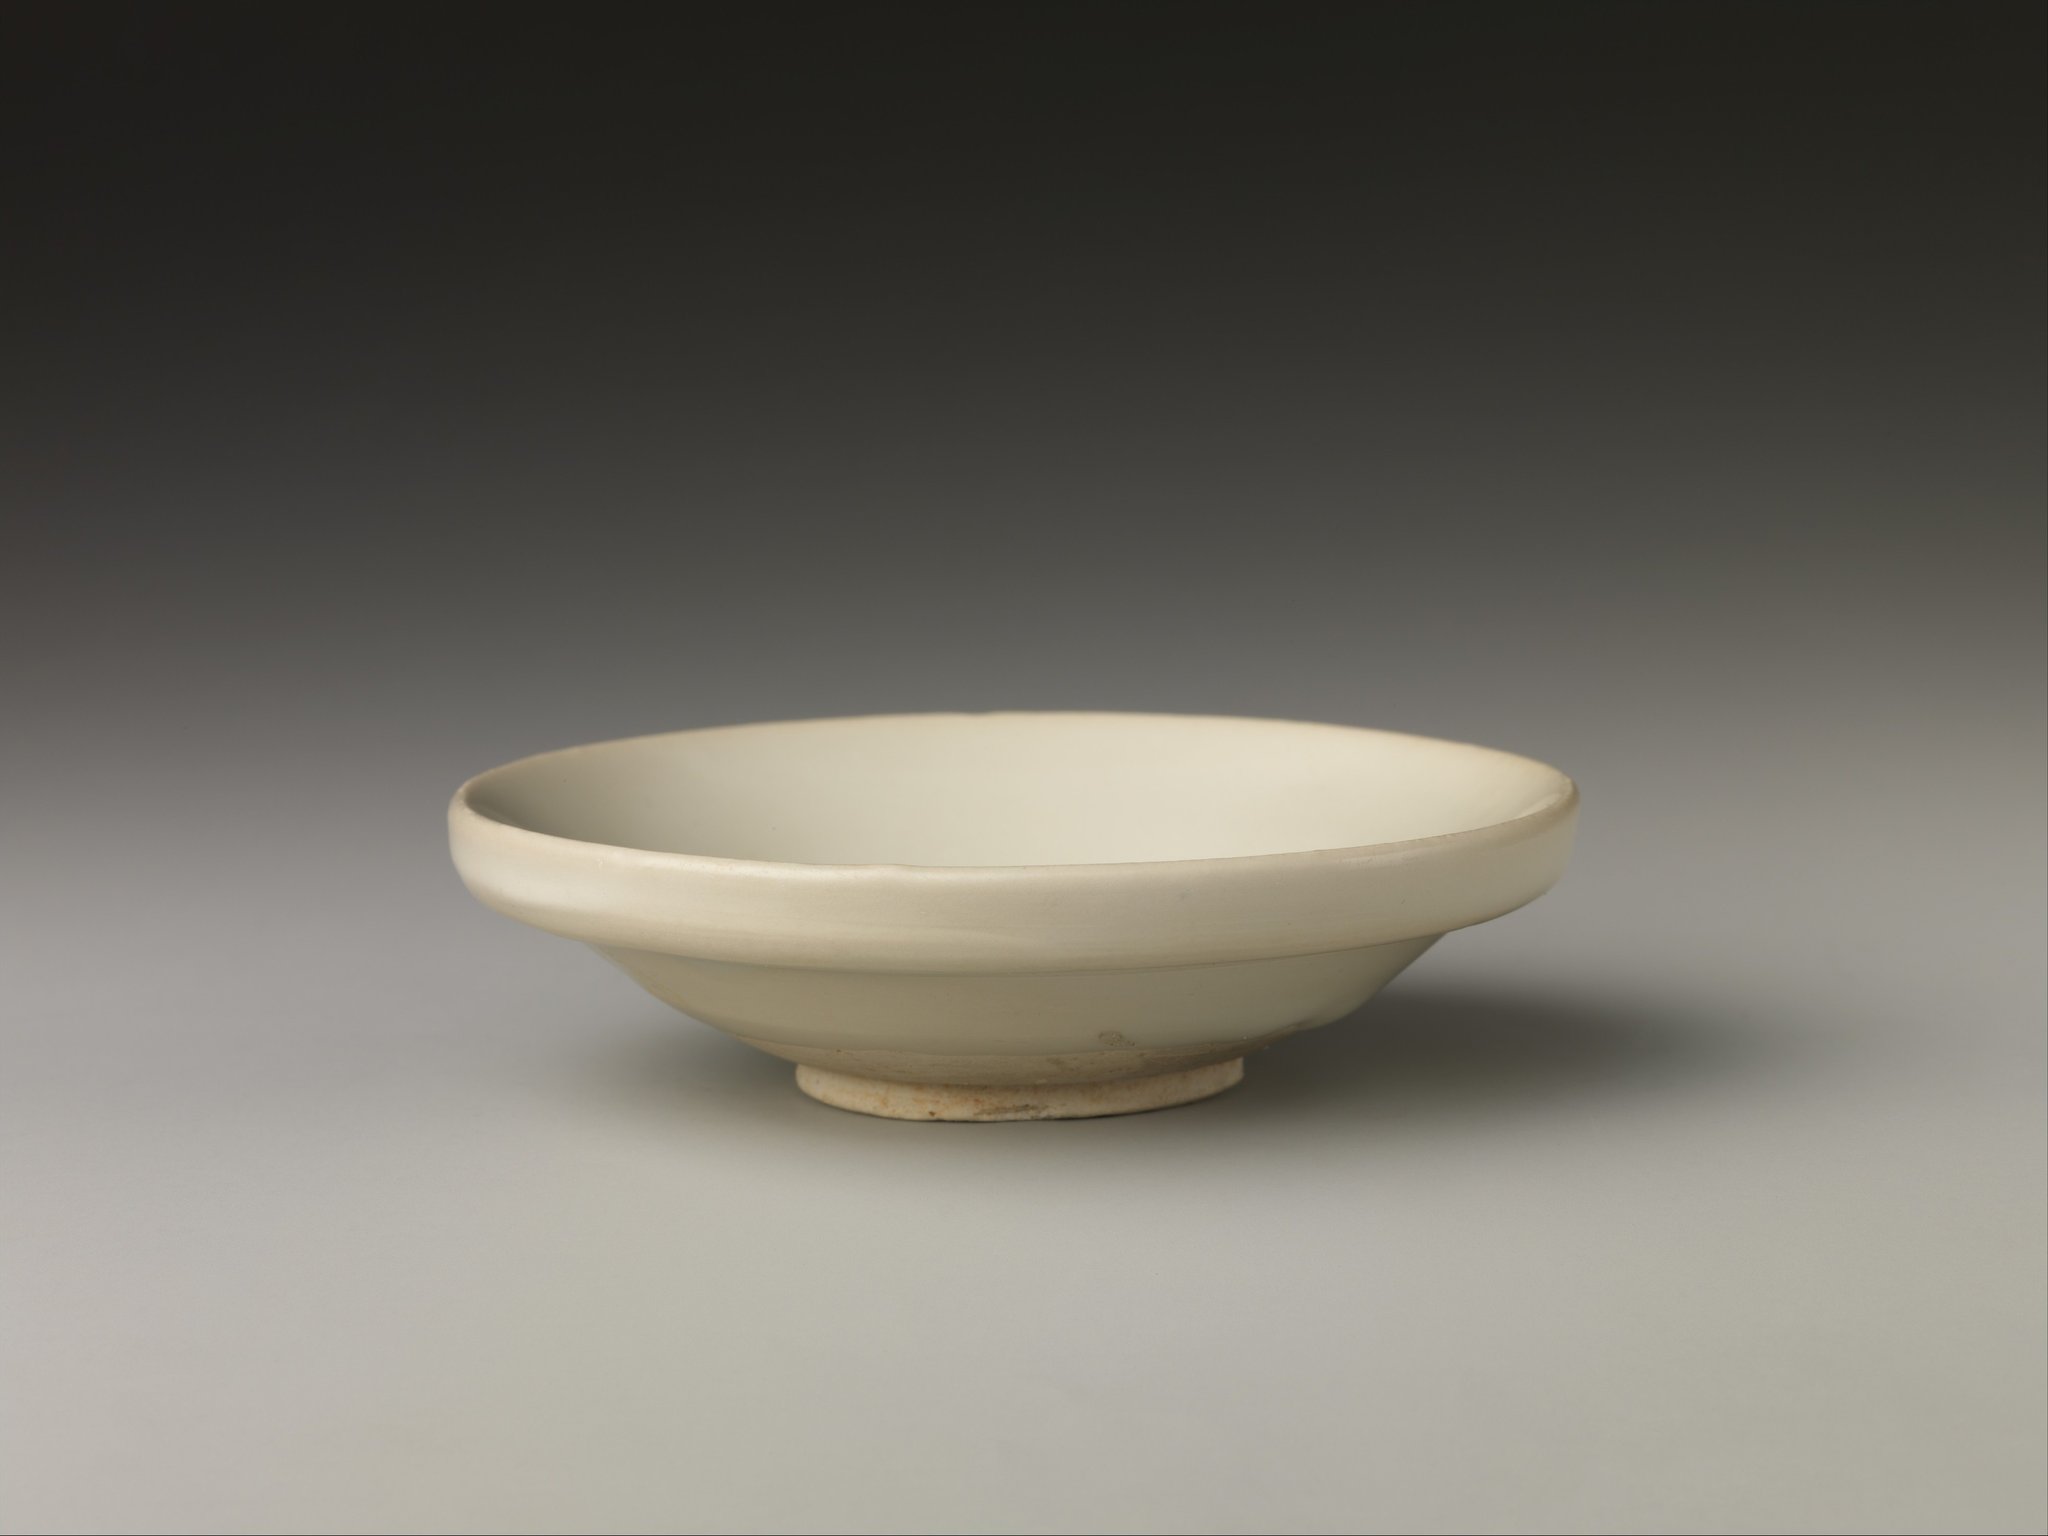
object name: bowl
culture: chinese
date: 801-900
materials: glaze, stoneware